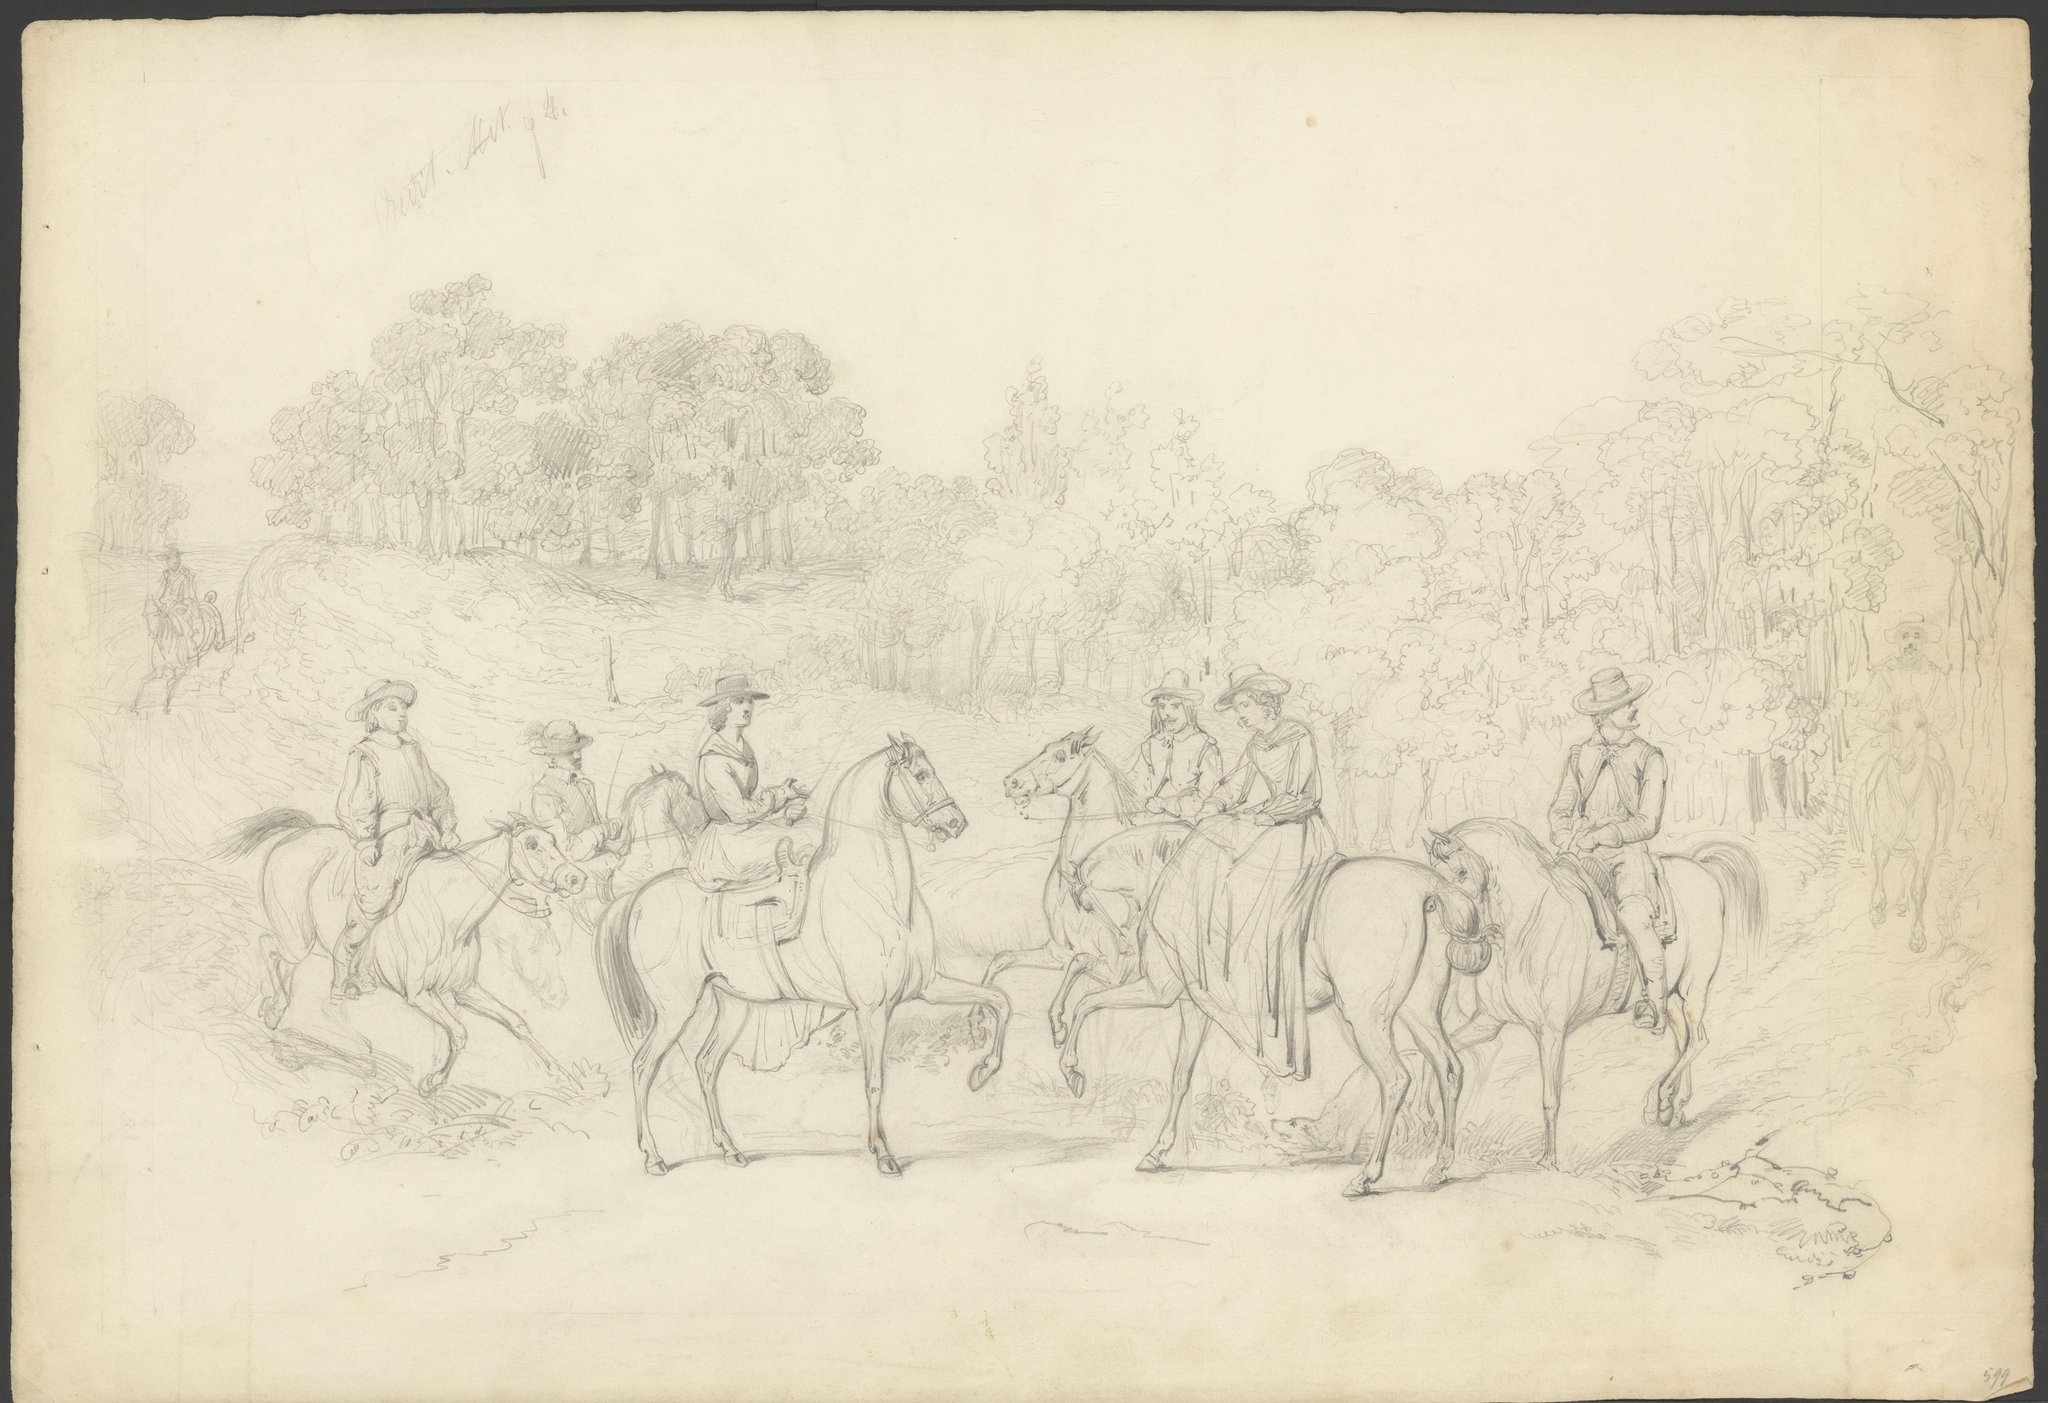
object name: drawing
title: Gezelschap te paard in het bos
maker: karel frederik bombled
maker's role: draughtsman, print maker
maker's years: 1822-1902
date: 1864-1902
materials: paper, pencil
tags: riding a horse, ass, or mule; rider, horseman, forest, wood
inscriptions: stamp, collector's mark: Lugt 1641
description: Ontwerp voor het AB boek van Karel Frederik Bombled. Onderwerpsrubrieken binnen de Atlas Zeden en Gewoonten: Schoone kunsten, Schilderkunst, Tekeningen.